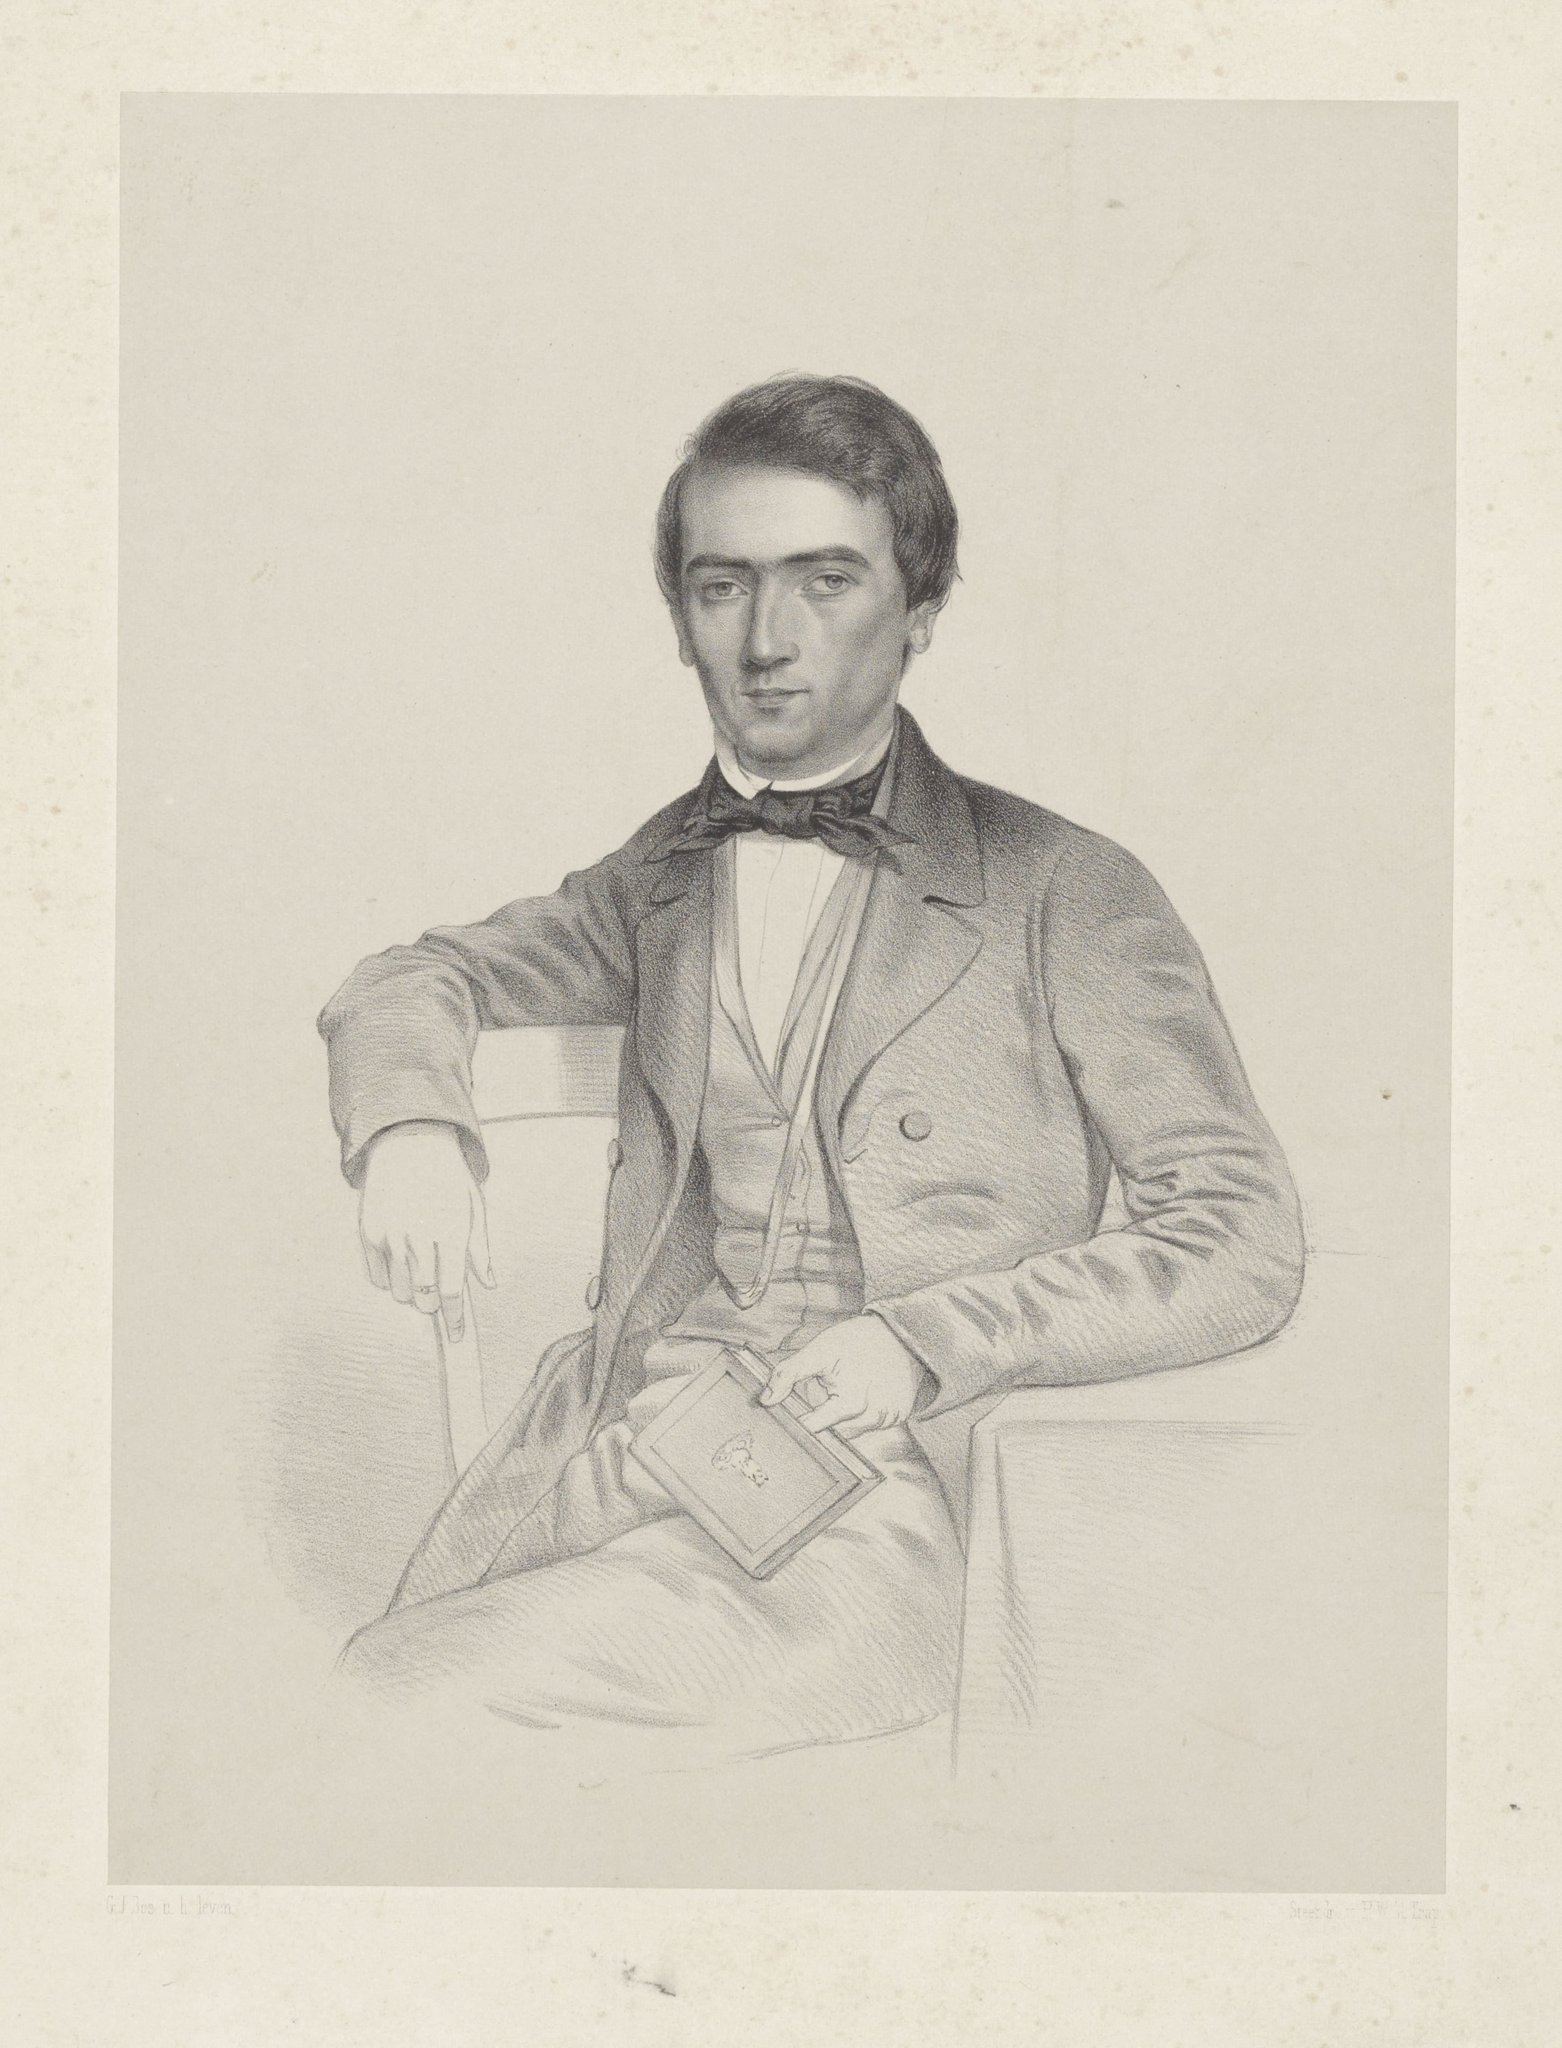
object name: print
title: Portret van een onbekende man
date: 1835-1898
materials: paper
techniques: lithograph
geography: netherlands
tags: historical persons, book, owls, sitting on an elevation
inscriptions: collector's mark: Lugt 2228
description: De geportretteerde zit naast een tafel op een stoel. Zijn rechterarm rust op de rugleuning. Zijn linkerarm steunt op de tafel en in zijn linkerhand heeft hij een boek. Op de kaft staat een uil afgebeeld.